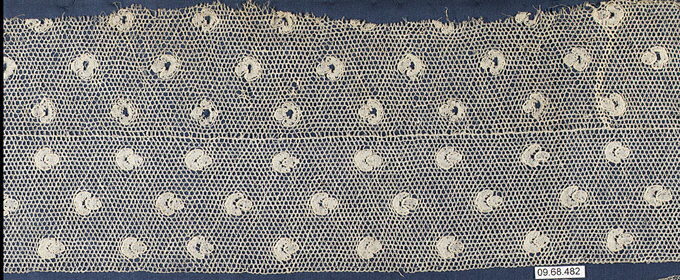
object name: insertion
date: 1801-1900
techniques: lace